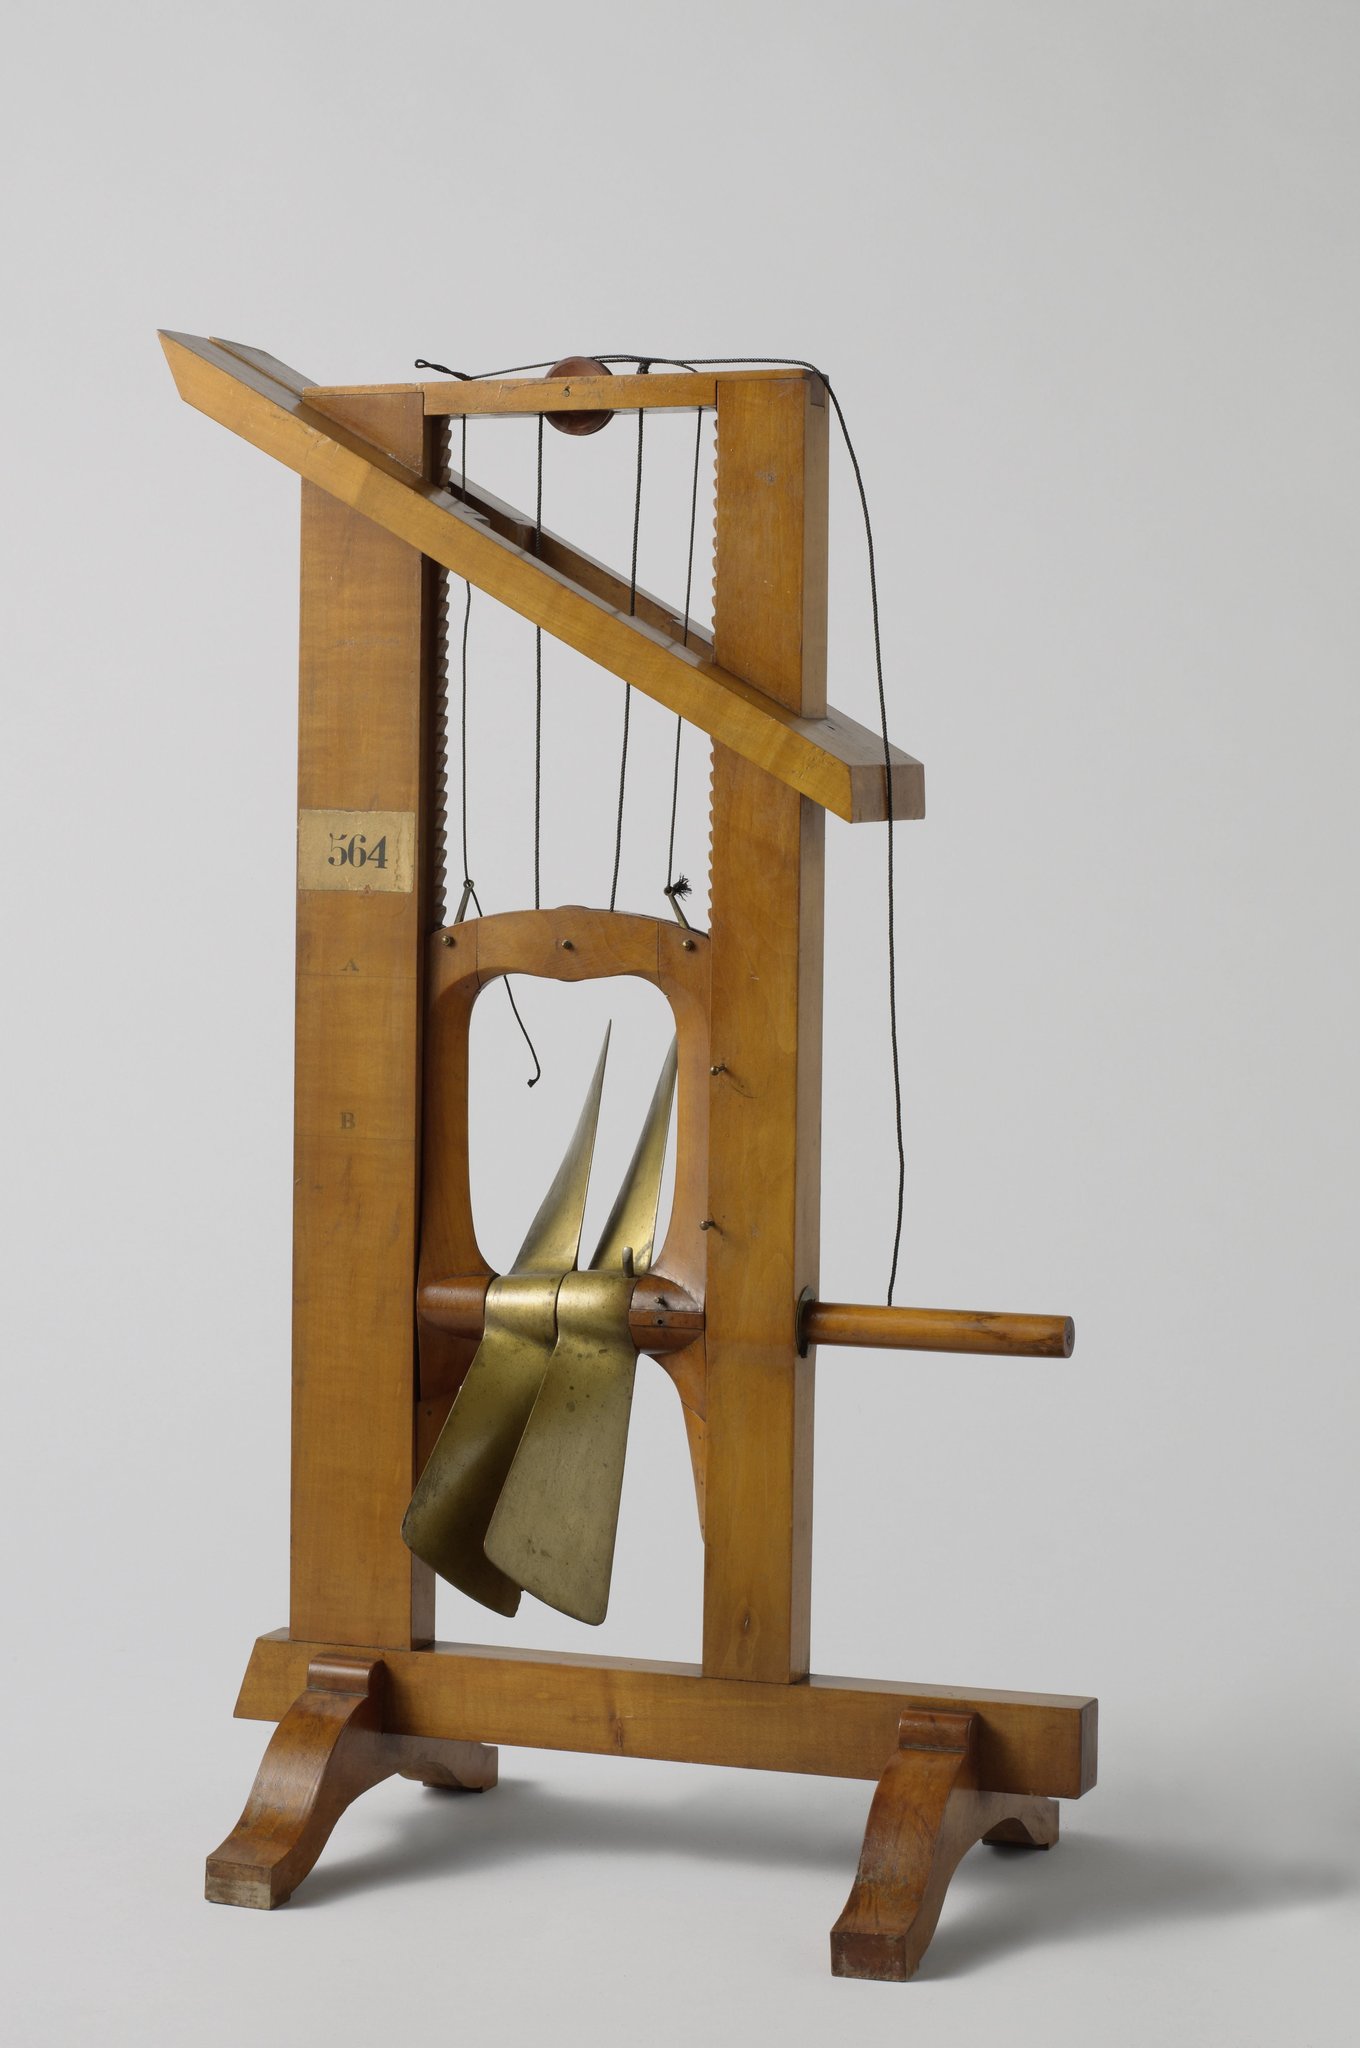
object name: demonstration model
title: Model of a Lifting Screw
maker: petrus van der loo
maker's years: 1806-1864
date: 1857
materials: fiber, wood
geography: netherlands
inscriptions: label, on the frame: ‘564’ former inventory label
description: P. van der Loo werd voor dit ontwerp geïnspireerd door een voorbeeld in het werk van Pâris over propellers en een tekening van het Franse fregat l'Impéreuse, die door tussenkomst van het Ministerie van Buitenlandse Zaken in 1857 door de Nederlandse Marine werd verkregen. De methode om de stand der schroeven te kunnen veranderen is door Van der Loo zelf uitgedacht. De bladen van de Mangin-schroef zijn smaller dan die van een gewone tweebladige schroef, waardoor het gat van de schroefkoker minder groot hoeft te zijn.